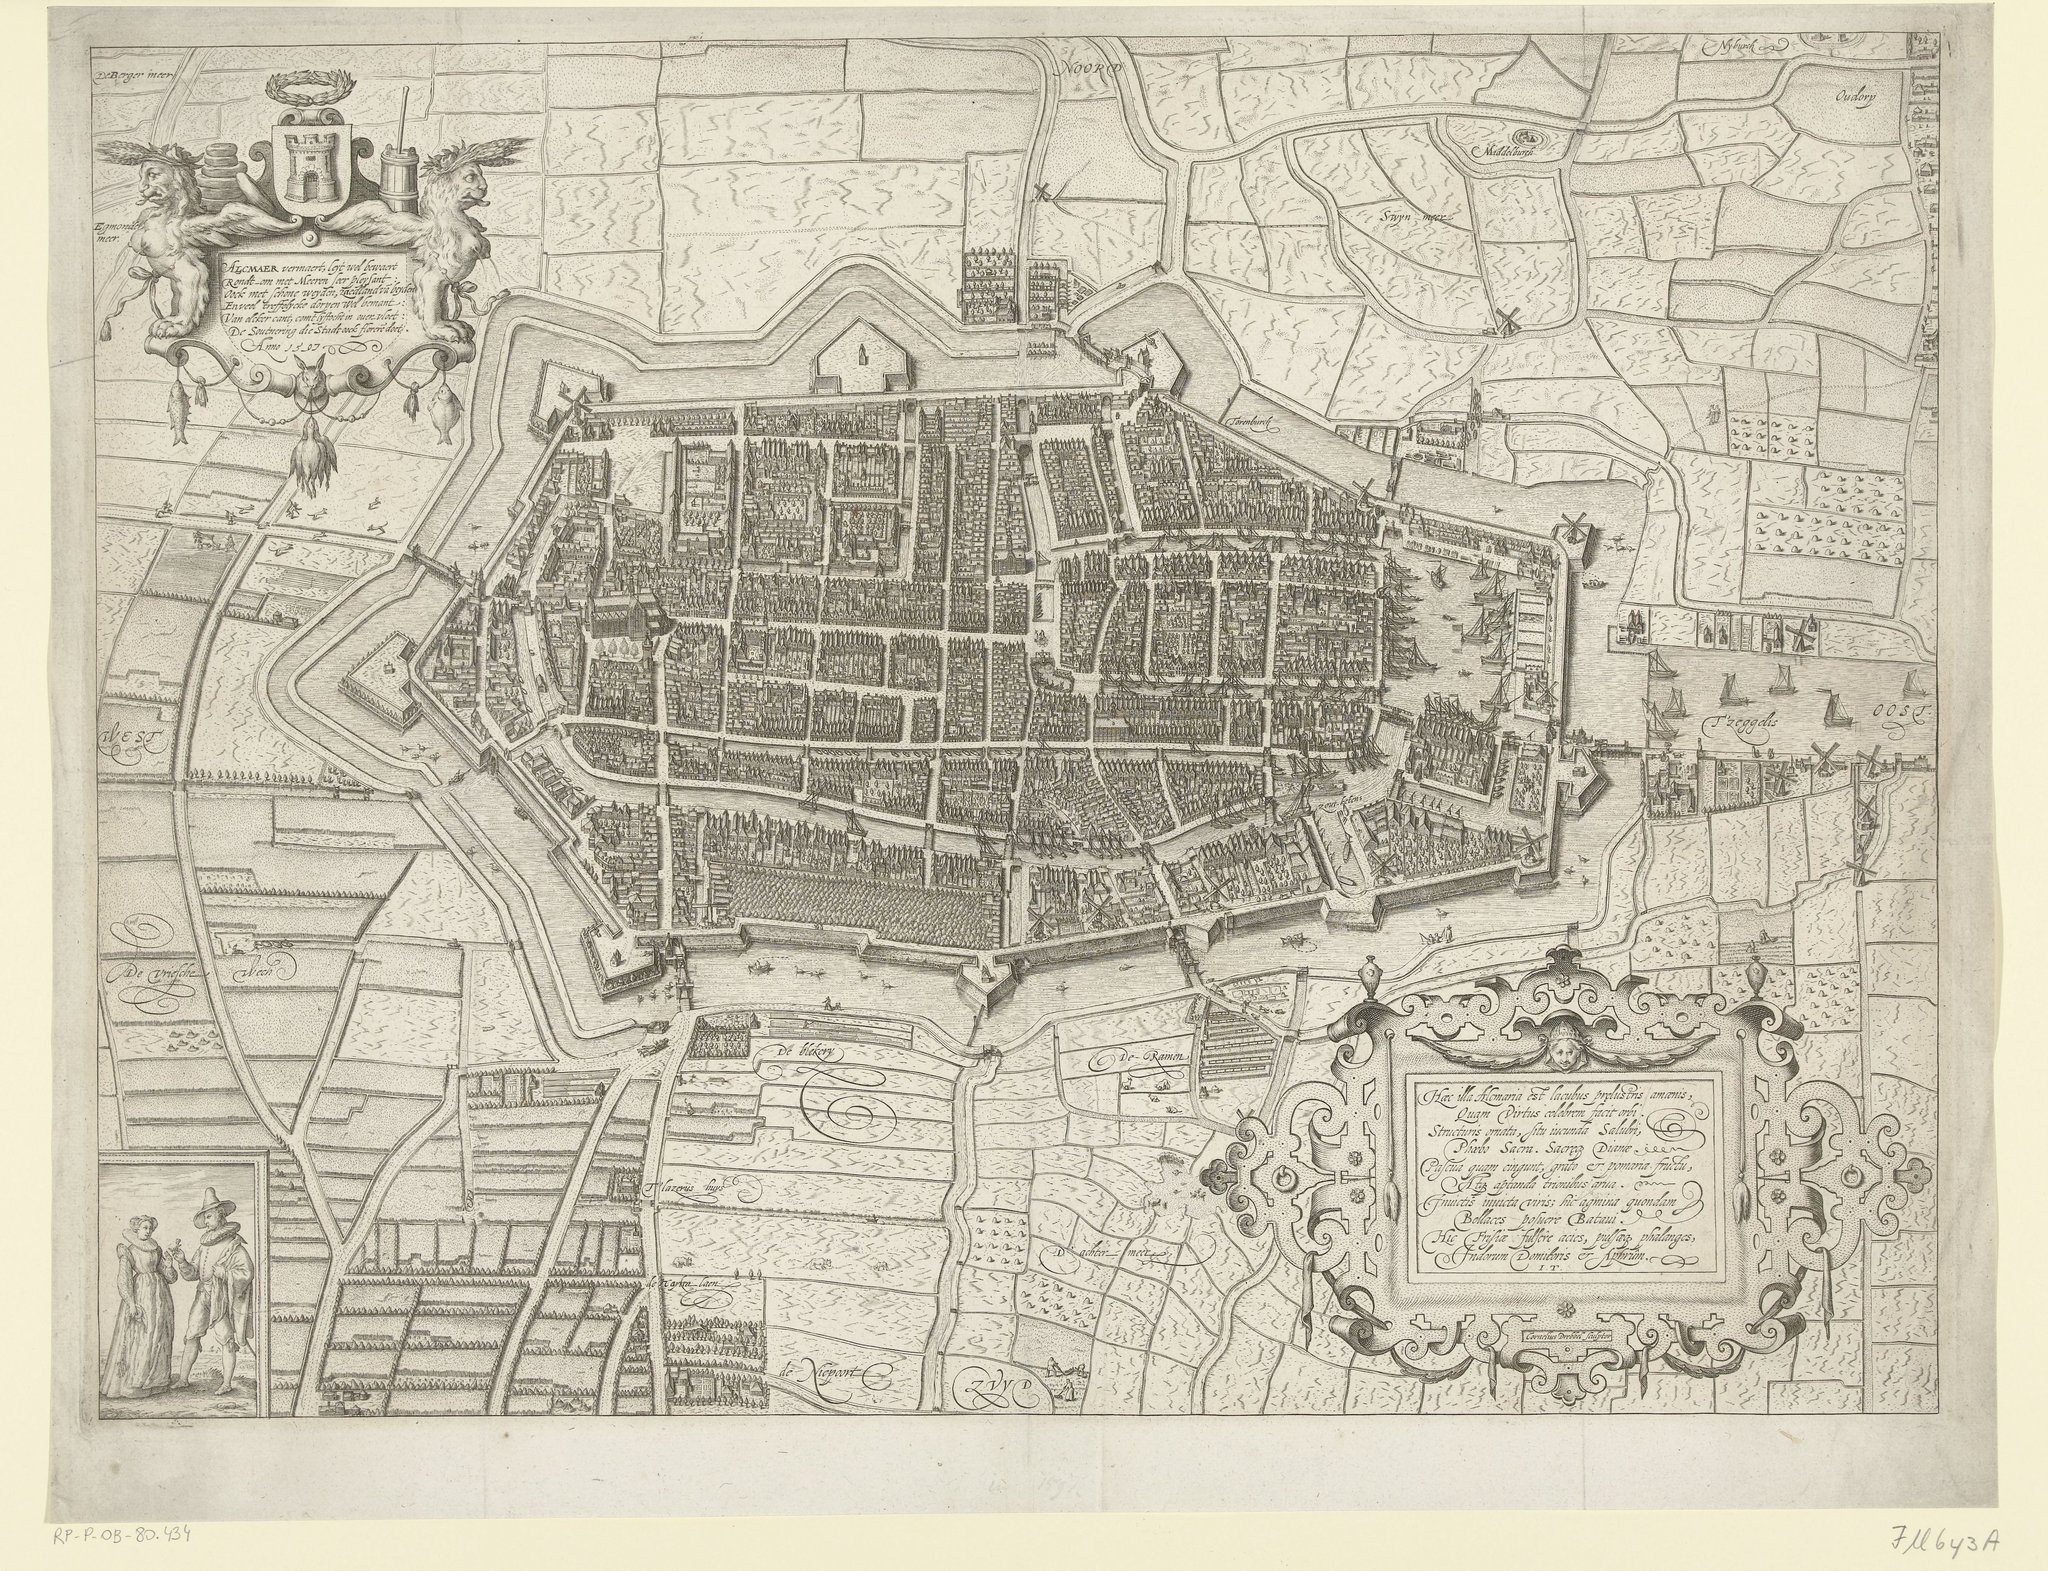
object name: print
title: Plattegrond van Alkmaar, 1597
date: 1597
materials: paper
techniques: engraving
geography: northern netherlands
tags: maps of cities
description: Plattegrond van de stad Alkmaar. Linksboven een cartouche versierd met sfinxen, kazen, boter, gevogelte en vissen en het stadswapen met een vers uit 1597 van 6 regels in het Nederlands. Rechtsonder een cartouche versierd met rolwerk met een vers van 10 regels in het Latijn. Linksonder een inzet met een man die een vrouw een bloem geeft.